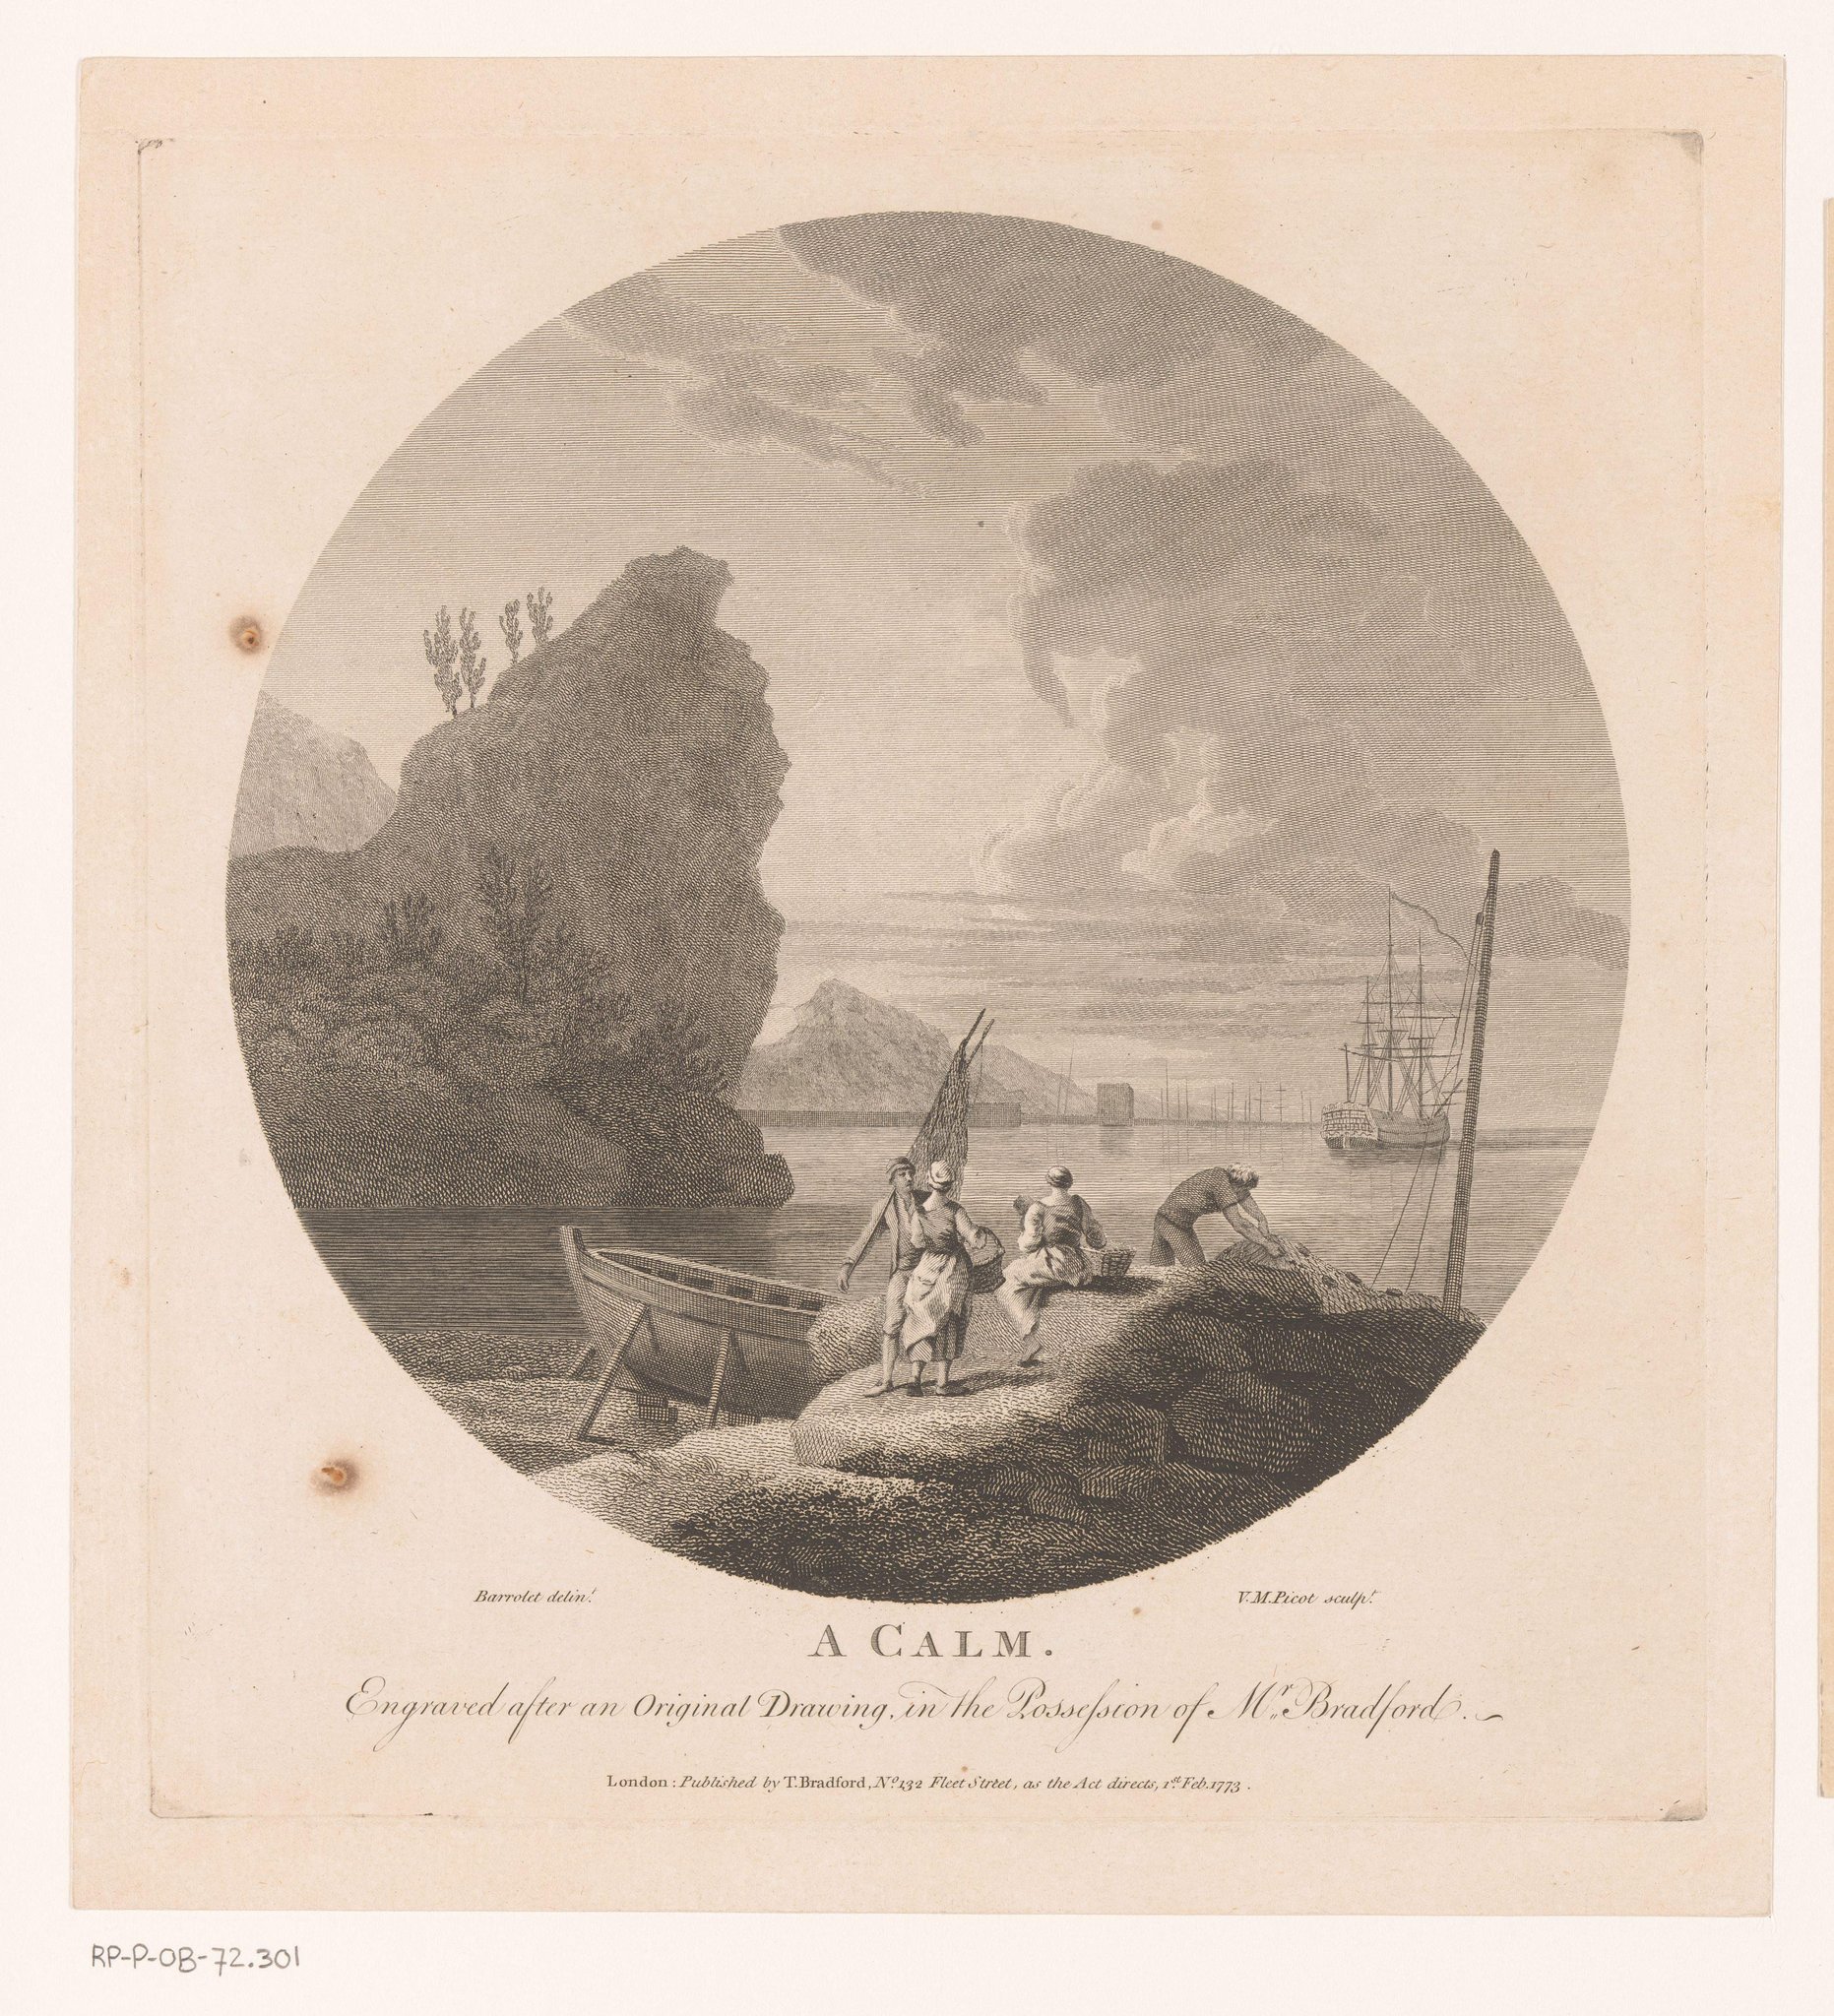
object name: print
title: Landschap met kalme zee en vissers op een rots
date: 1773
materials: paper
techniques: engraving, etching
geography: london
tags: sea (seascape), fisherman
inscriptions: collector's mark: Lugt 2228